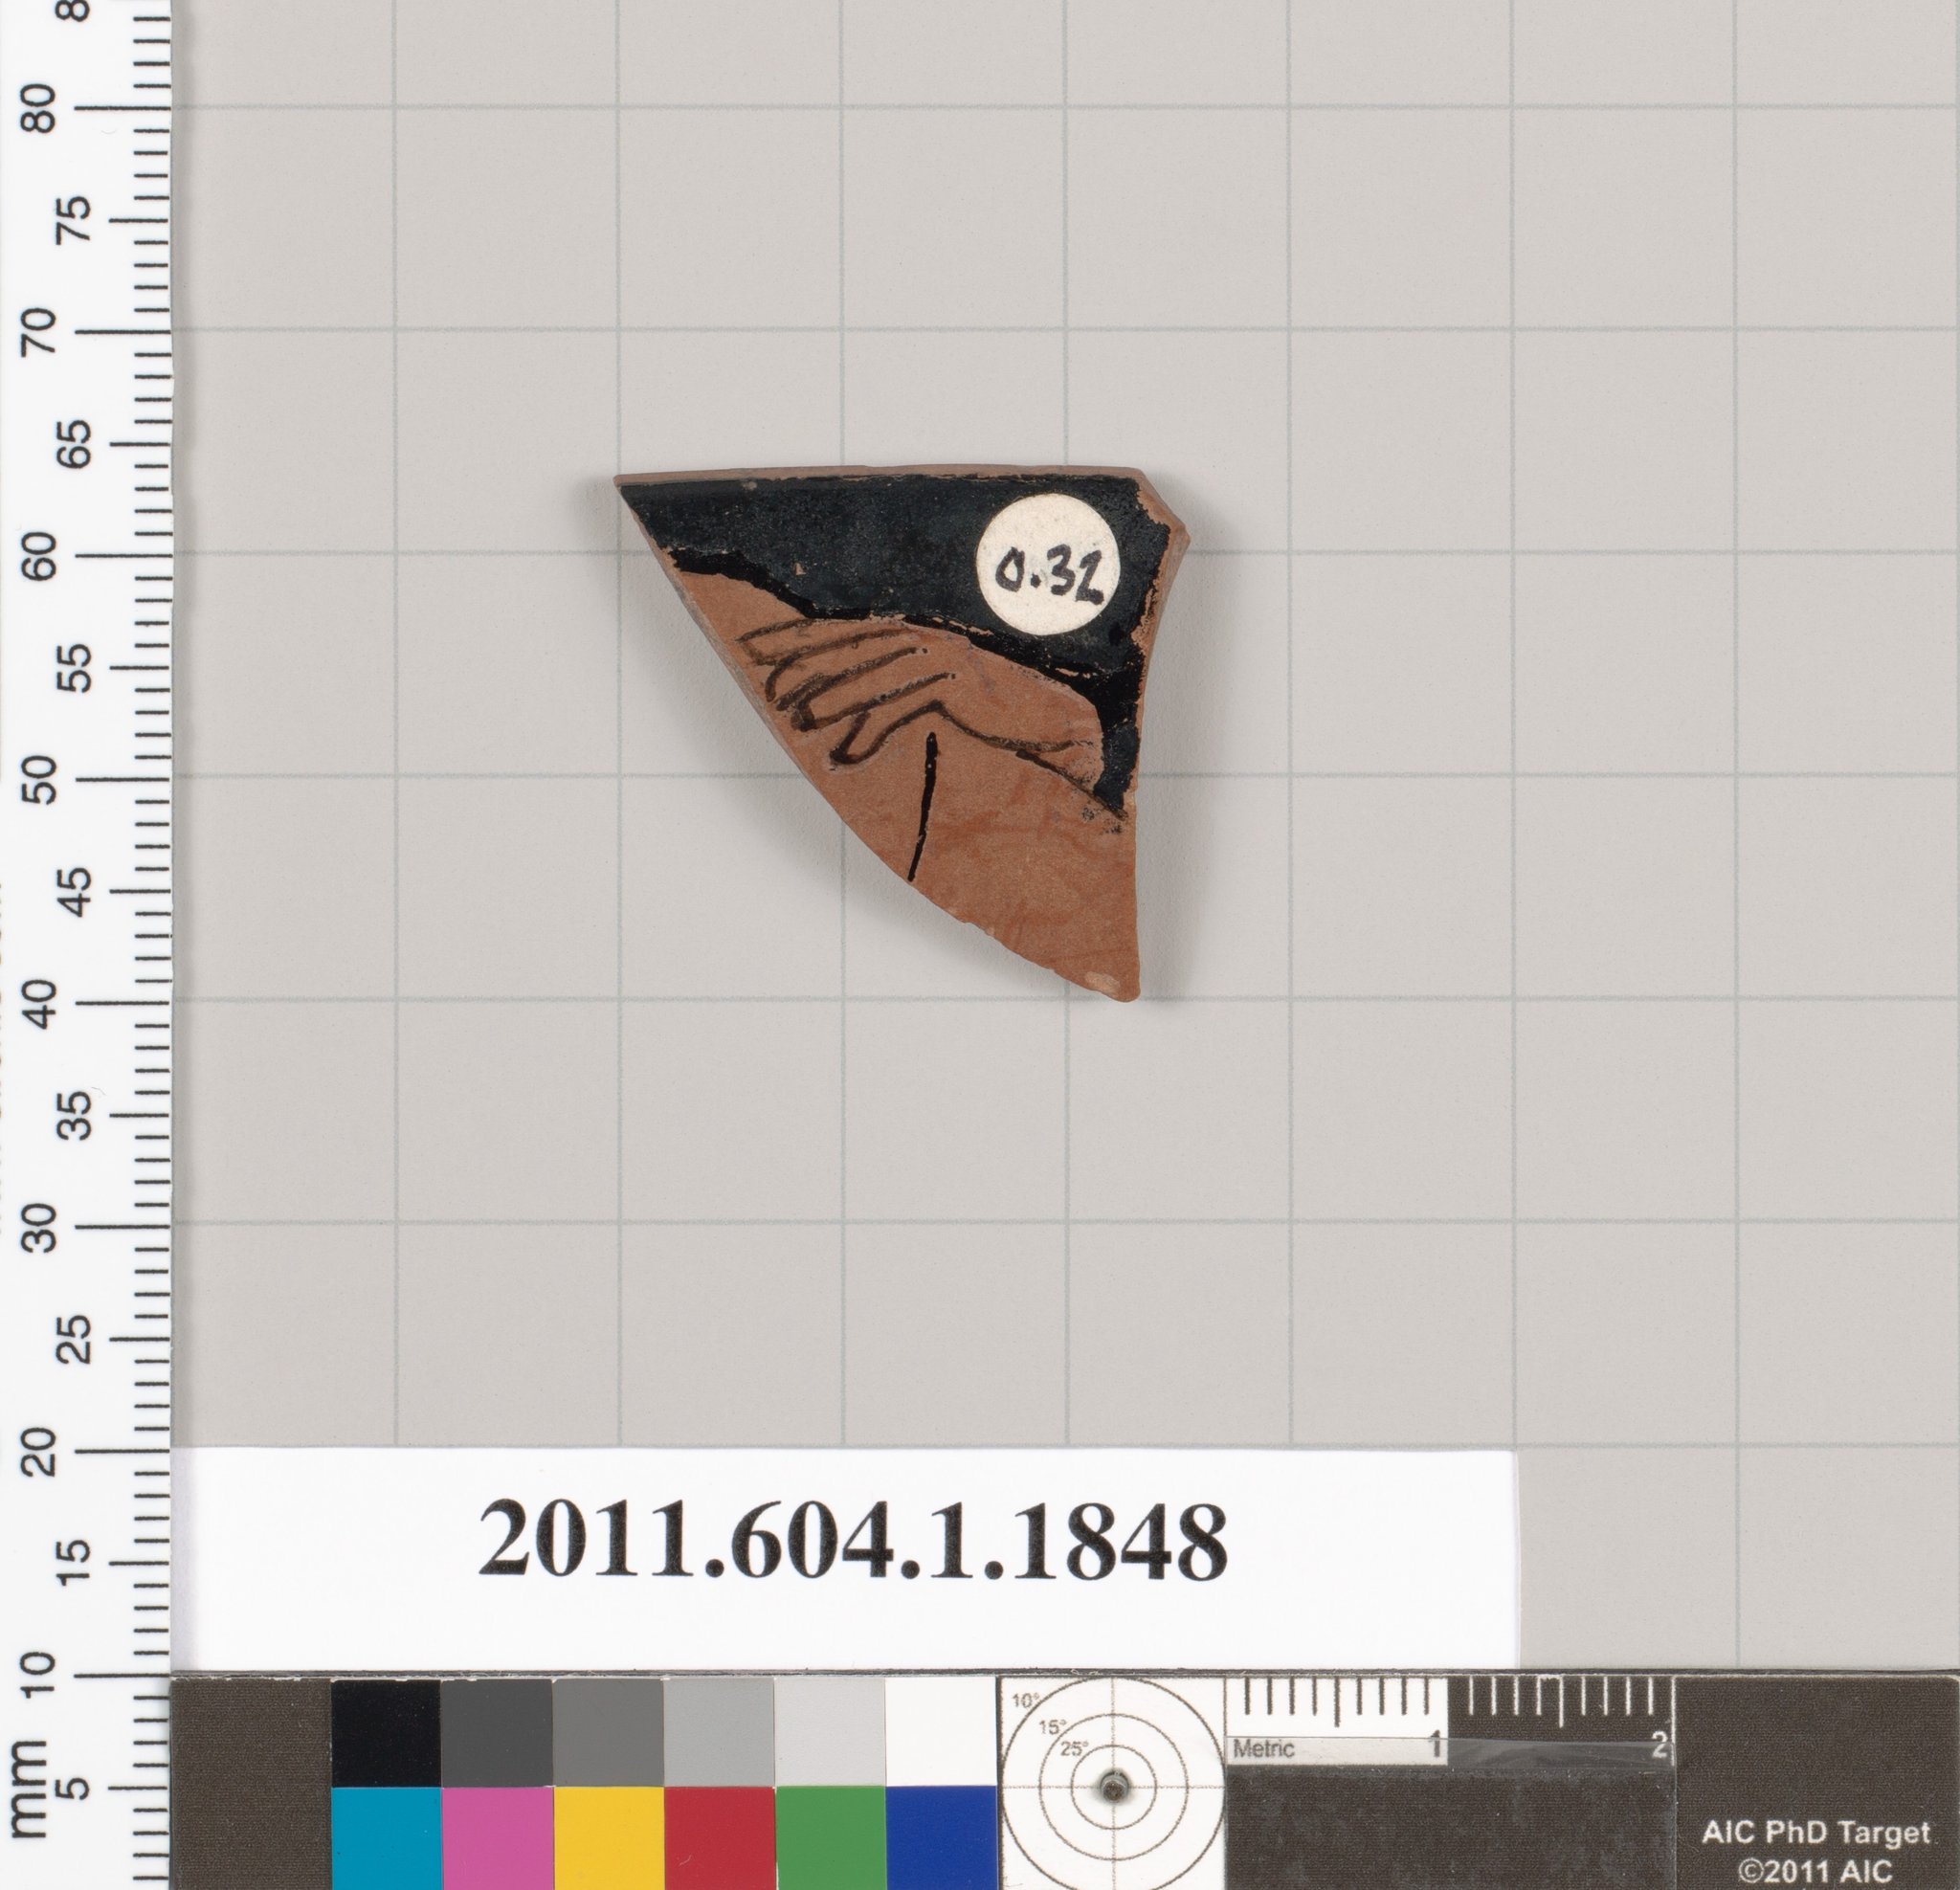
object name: kylix fragment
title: Terracotta rim fragment of a kylix (drinking cup)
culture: greek, attic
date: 475-451 BCE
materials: terracotta